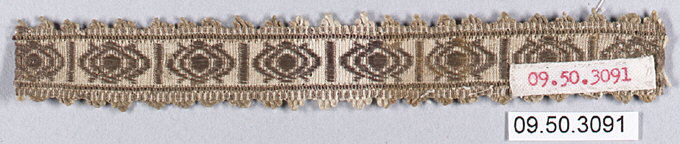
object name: gimp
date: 1701-1900